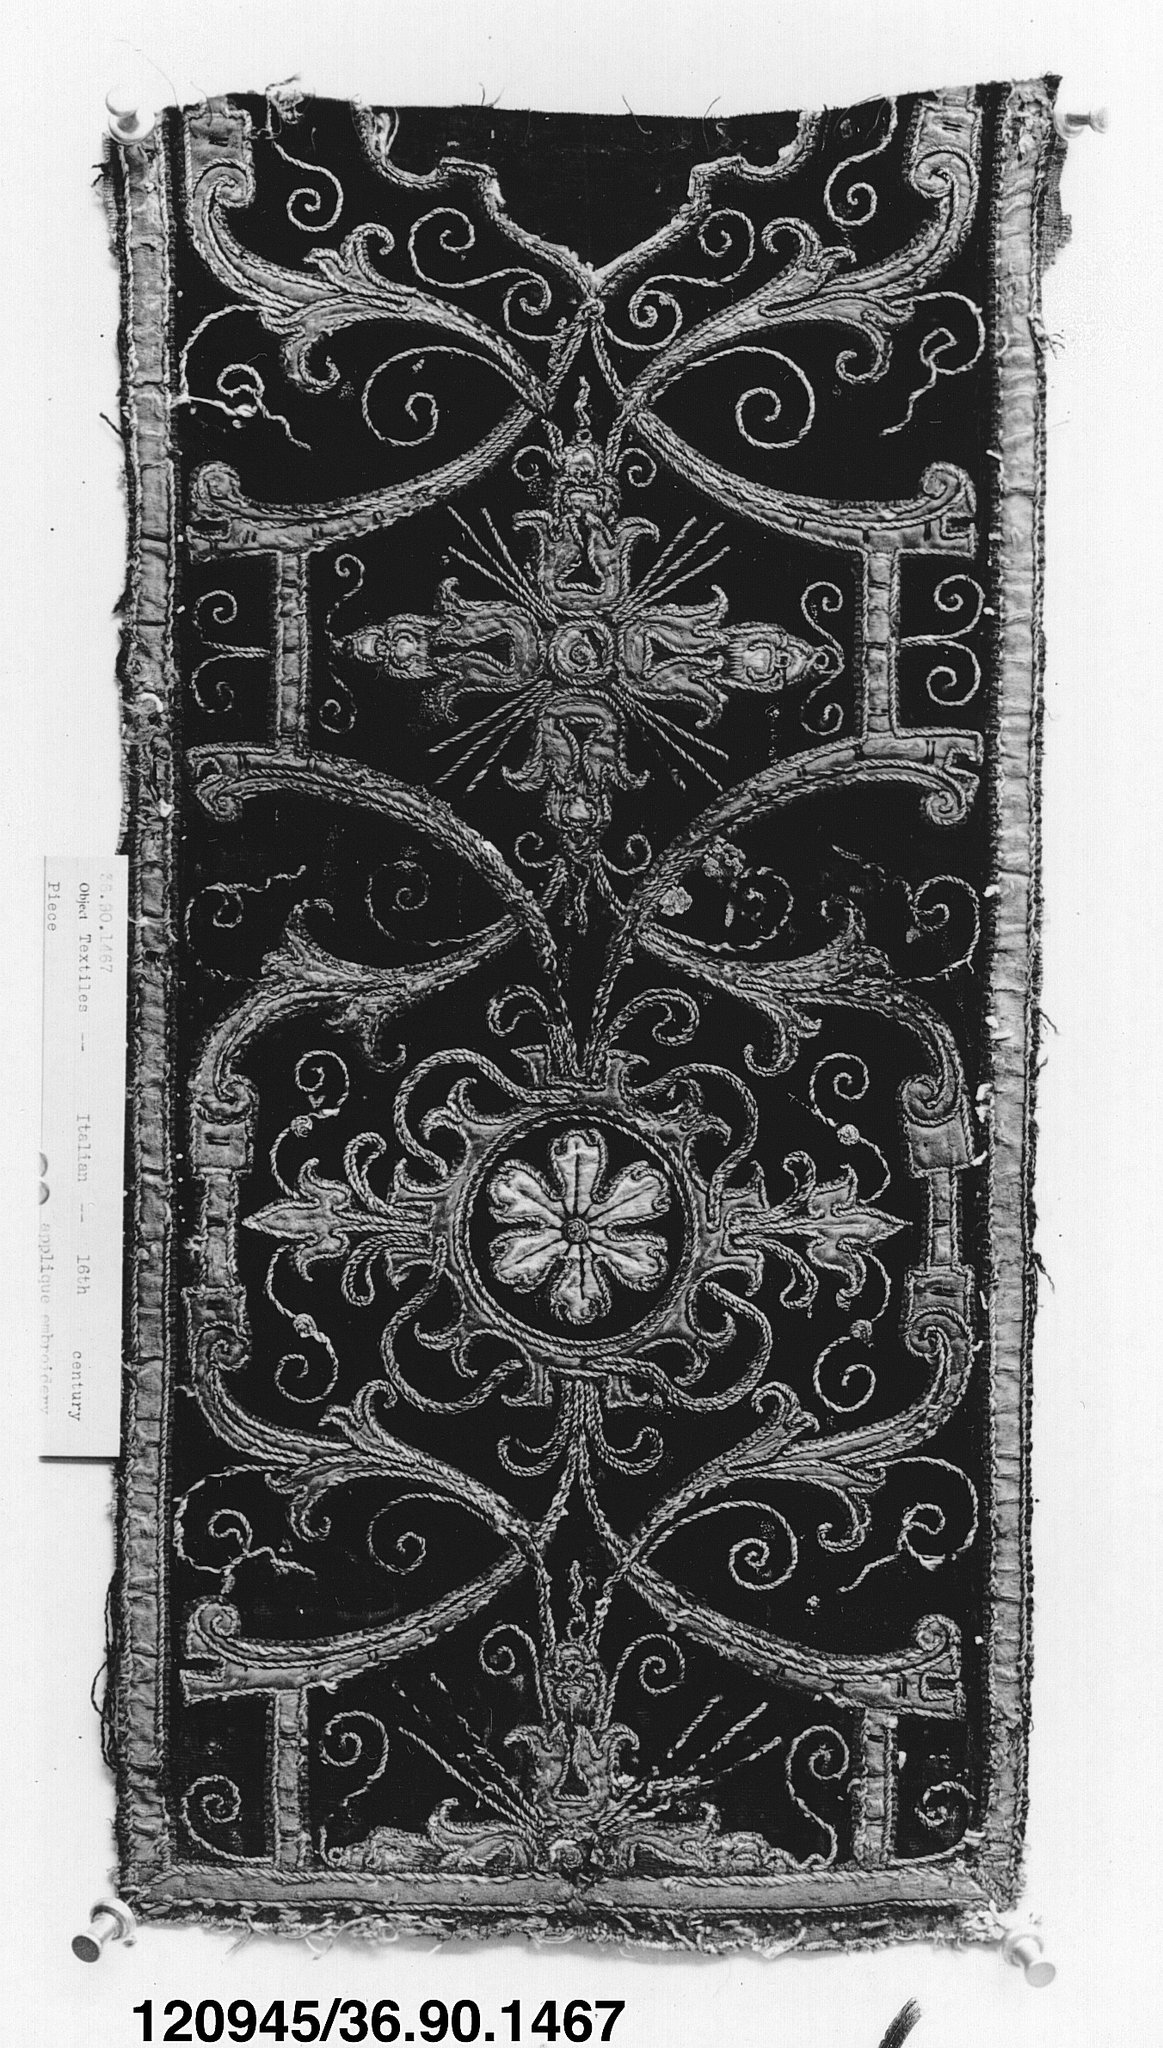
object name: piece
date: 1501-1600